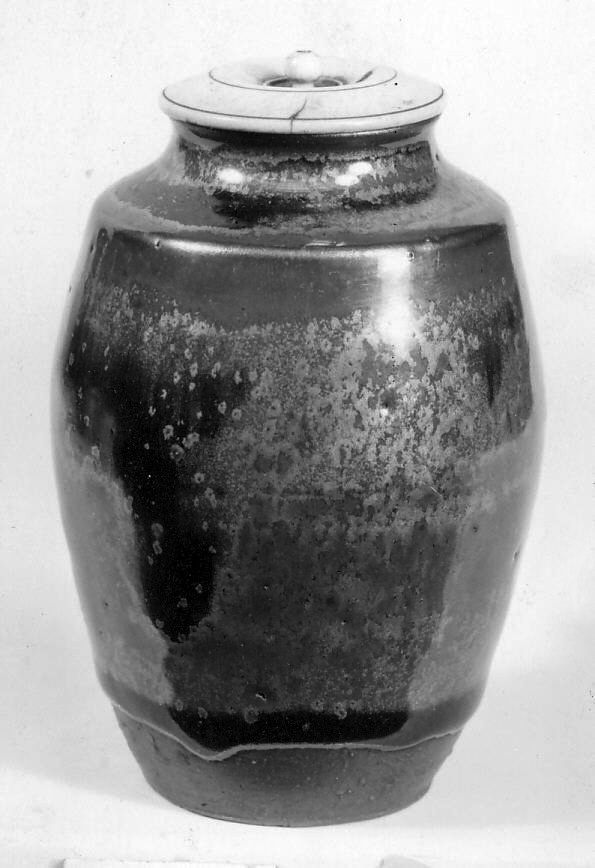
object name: tea jar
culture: japanese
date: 1701-1800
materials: clay, glaze